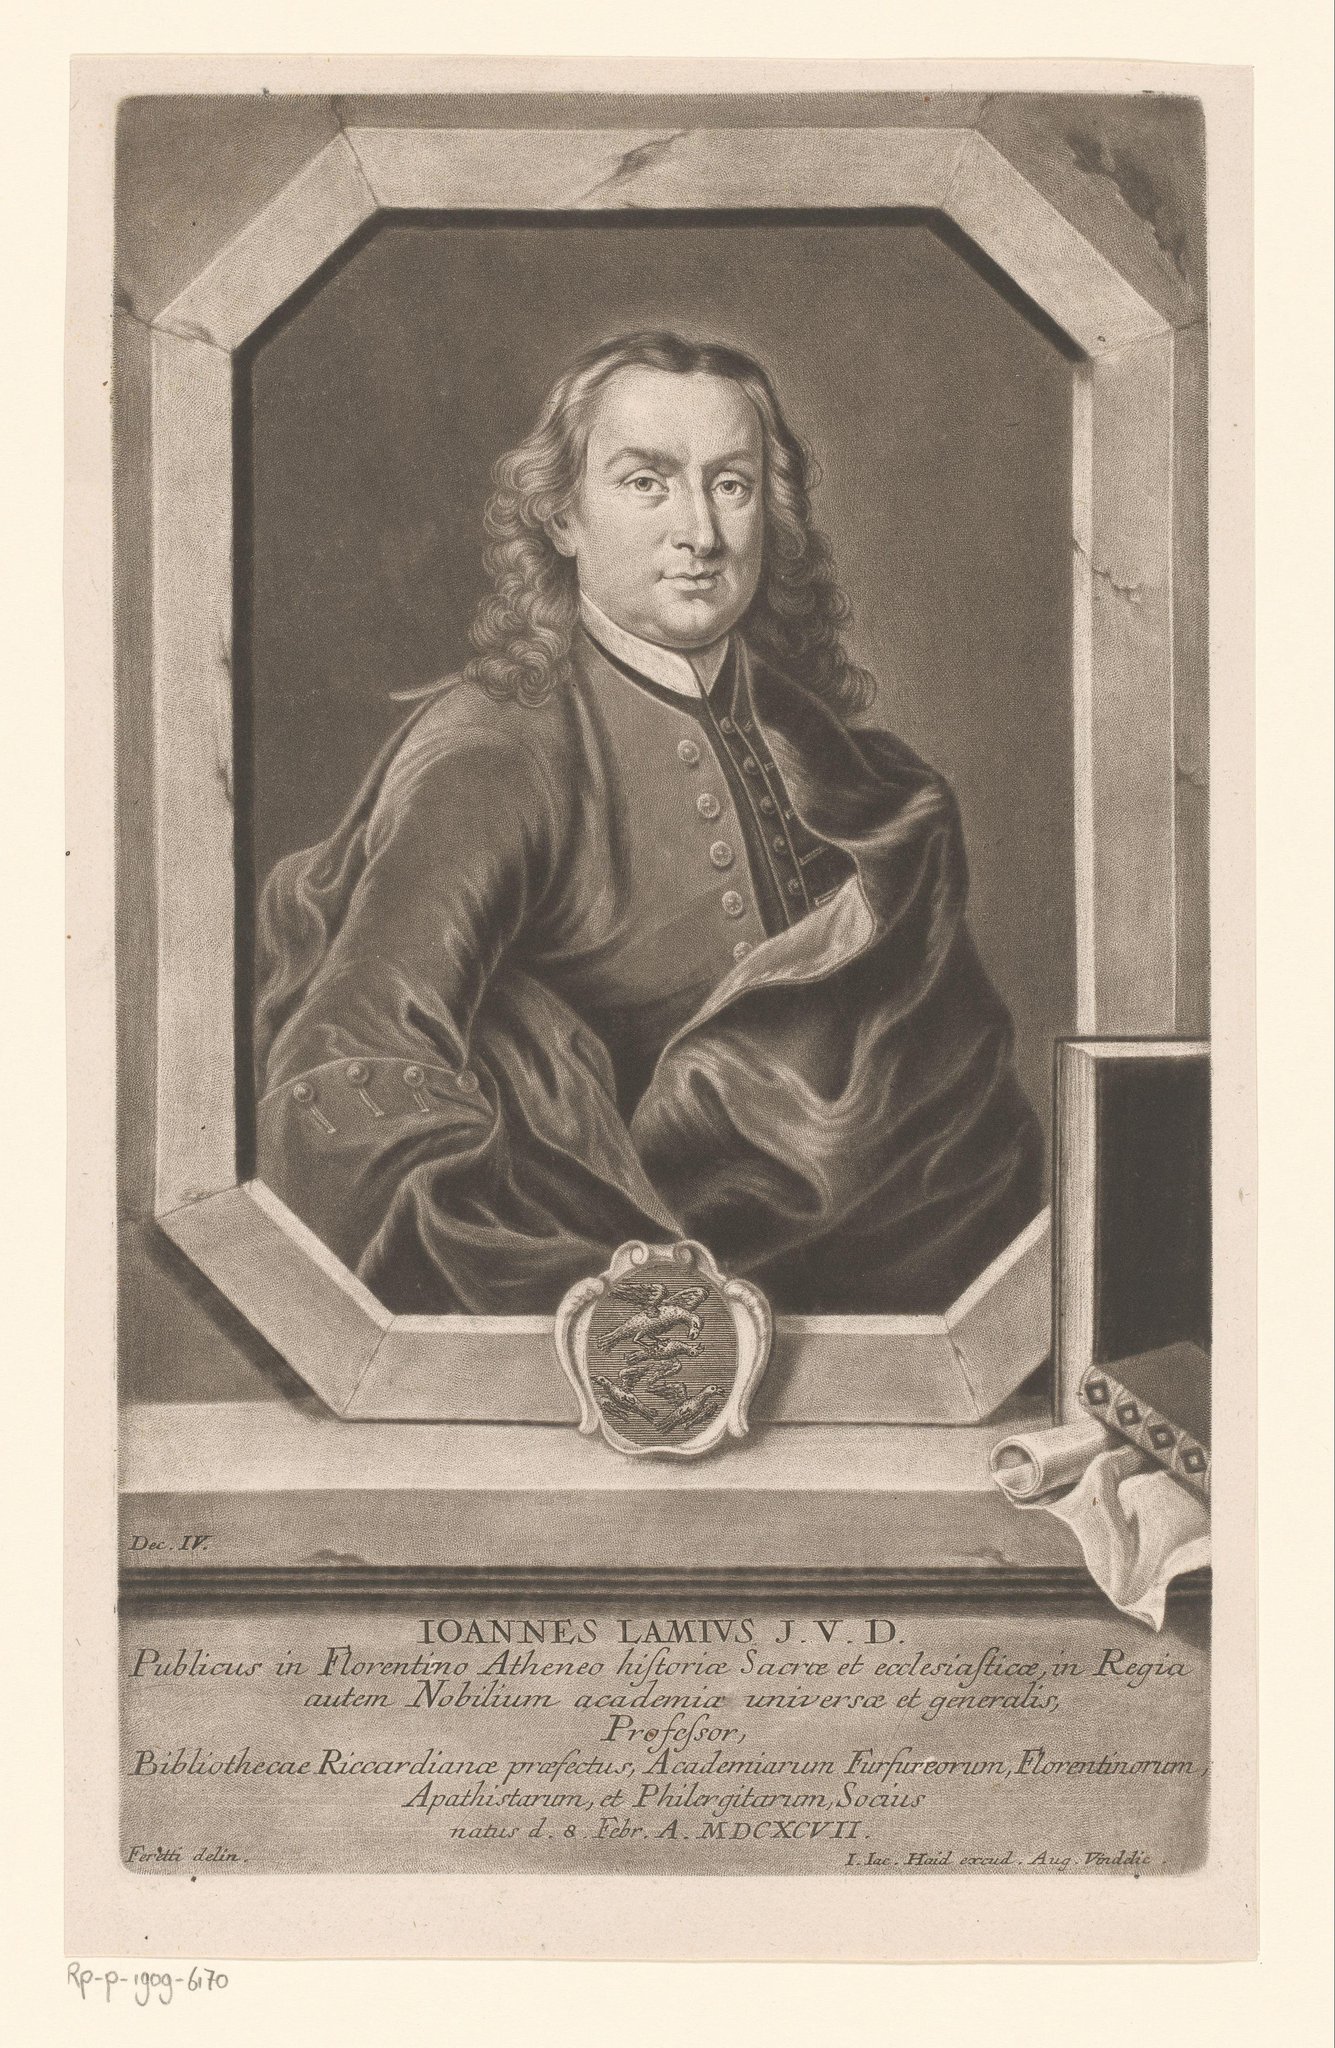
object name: print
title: Portret van Giovanni Lami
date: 1745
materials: paper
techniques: etching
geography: augsburg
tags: historical persons, book, armorial bearing, heraldry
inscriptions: collector's mark: Lugt 2228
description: Prent gebruikt voor: Brucker, Jacob. Bildersal heutiges Tages lebender und durch Gelahrheit berühmter Schrifftsteller. Augsburg: Johann Jacob Haid, 1745.